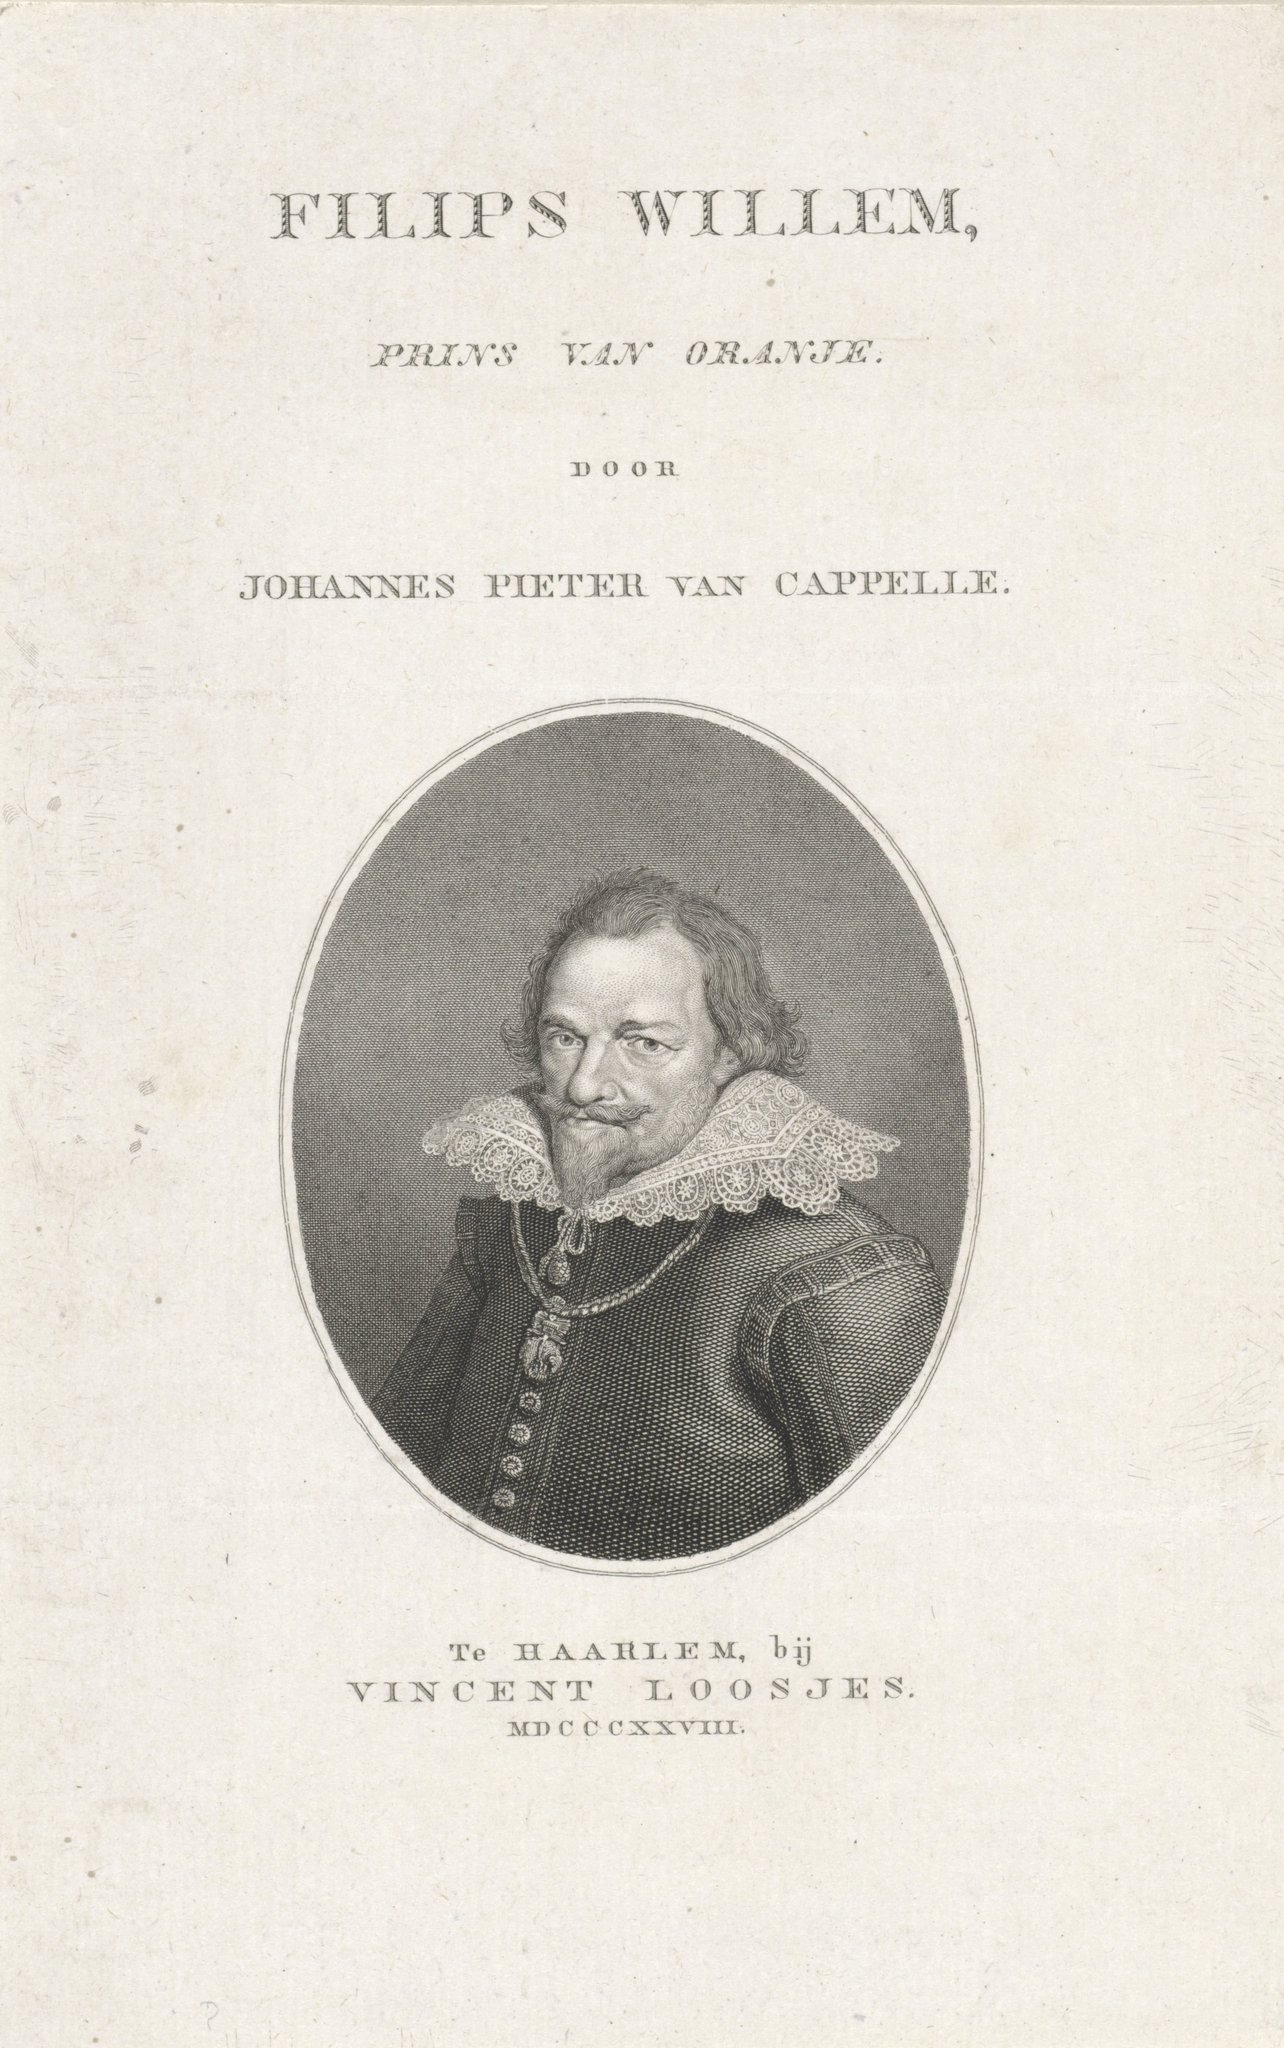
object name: print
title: Portret van Filips Willem, prins van Oranje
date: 1828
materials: paper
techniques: engraving, etching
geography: haarlem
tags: buren, bruges, filips willem (prins van oranje), knighthood order of the golden fleece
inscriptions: collector's mark: Lugt 2228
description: Portret van Filips Willem, prins van Oranje, met om zijn hals een ketting met het teken van de Orde van het Gulden Vlies.